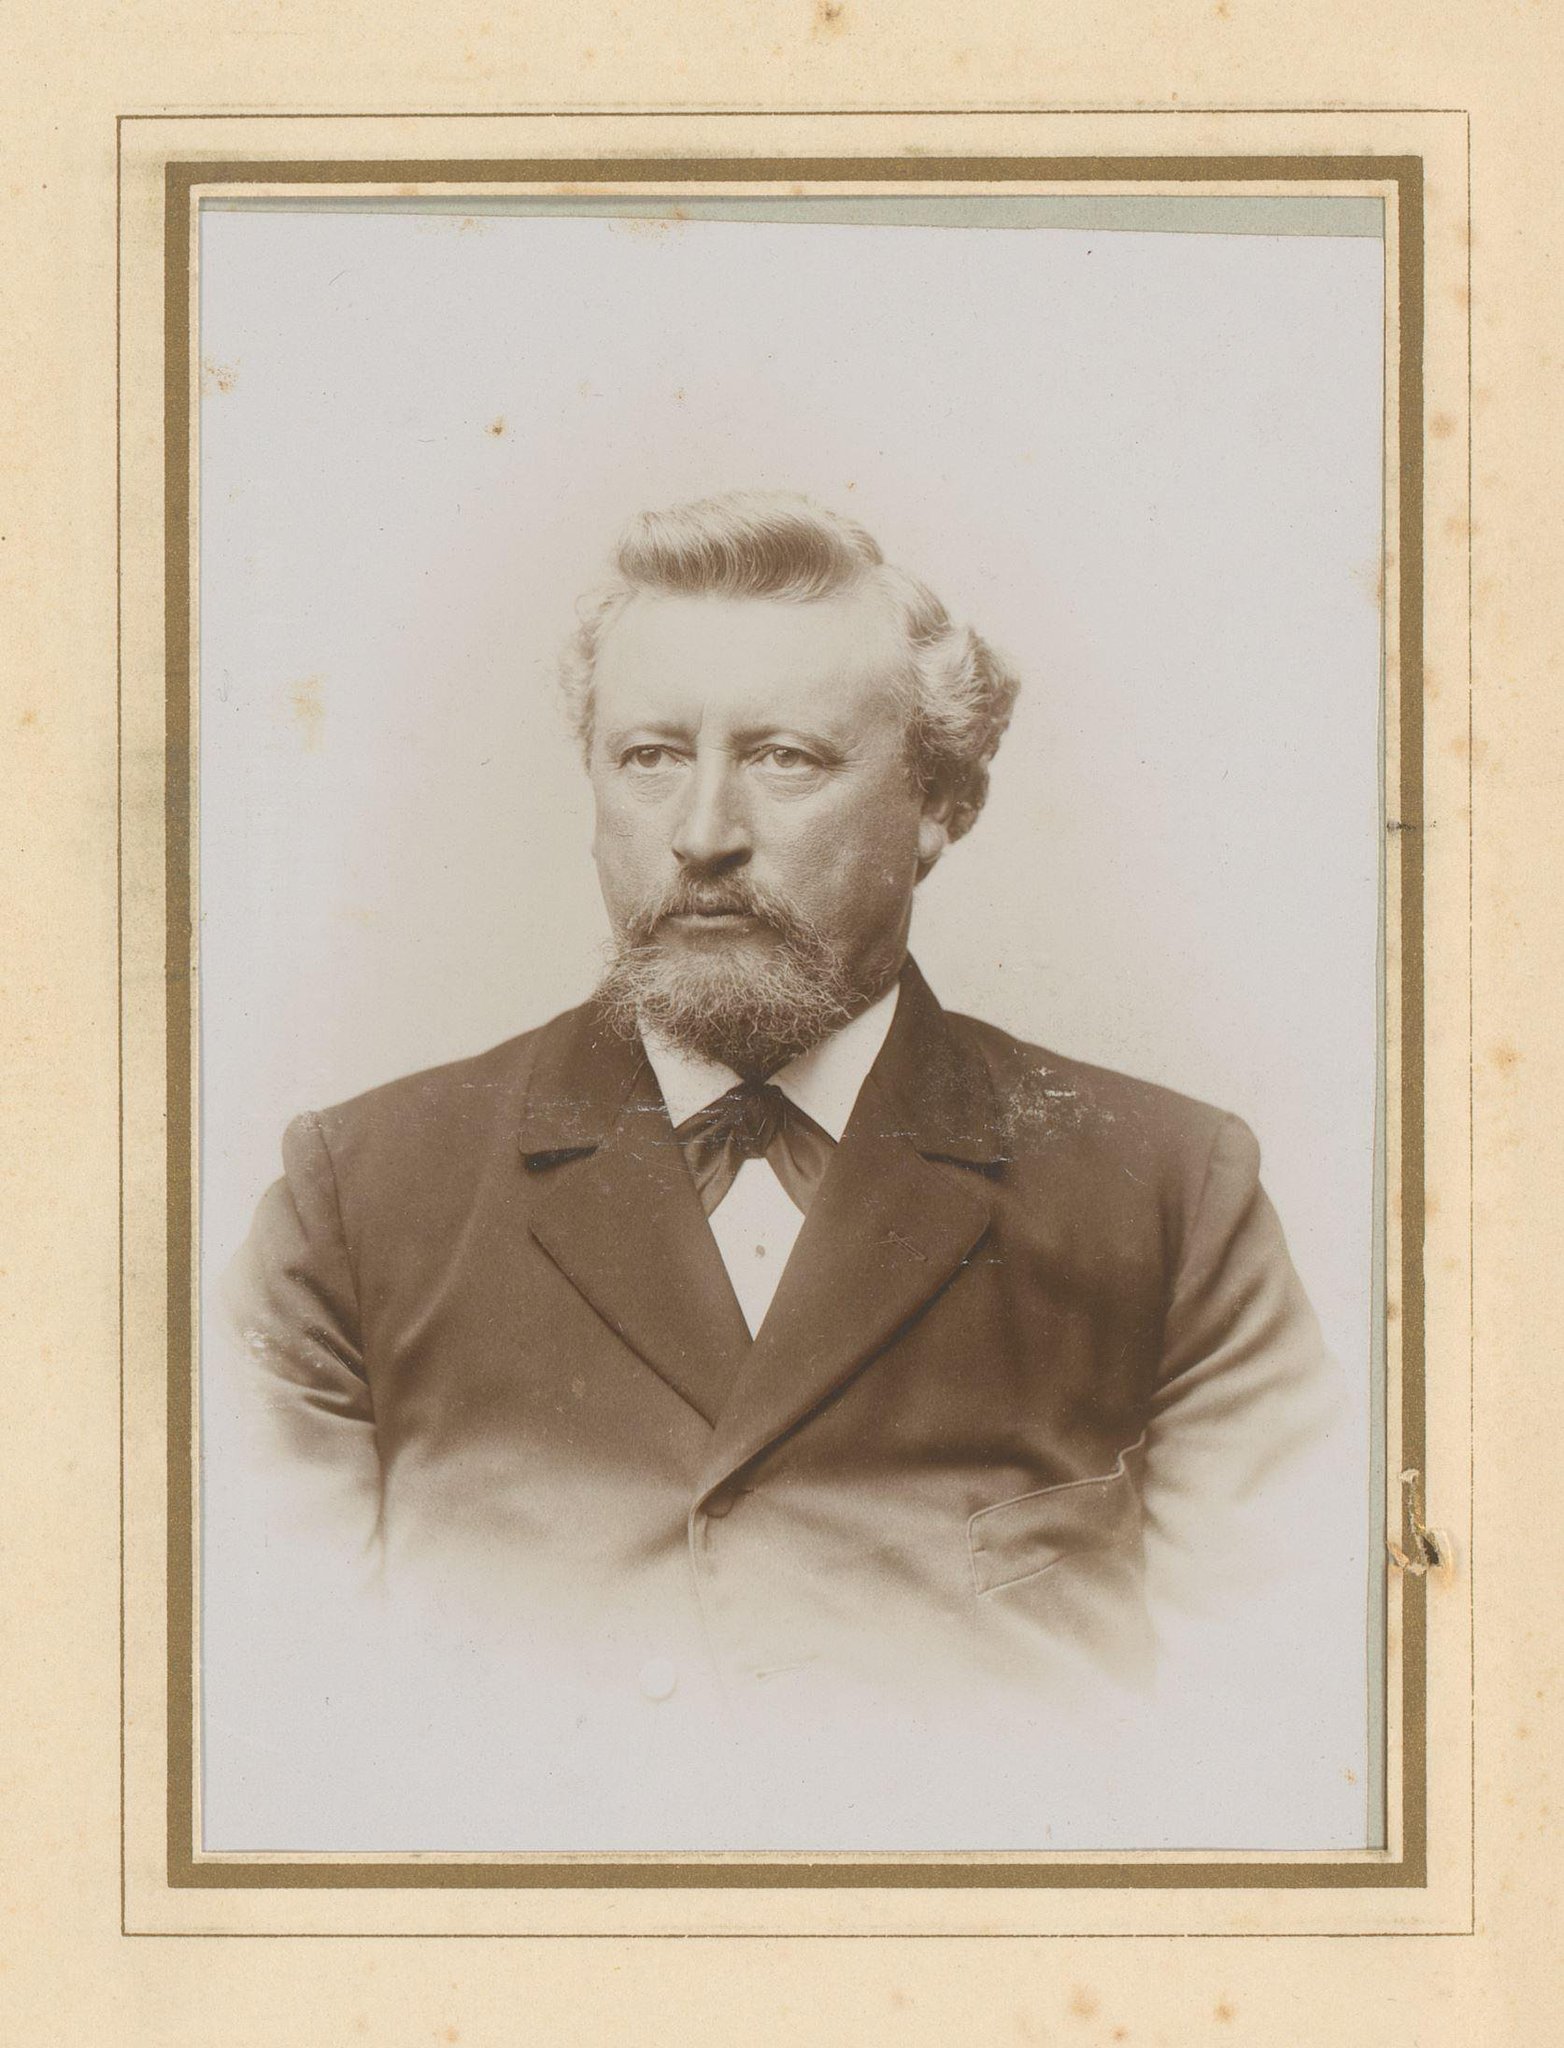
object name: album leaf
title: Portret van een man met snor en baard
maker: johan gerard lubbers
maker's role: fotograaf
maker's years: 1849-1923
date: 1891-1907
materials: cardboard, photographic support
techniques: collodion silver print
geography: rotterdam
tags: moustache, historical persons, beard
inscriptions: inscription: ‘J. G. Lubbers/ Rotterdam/ van der Takstraat 8.’